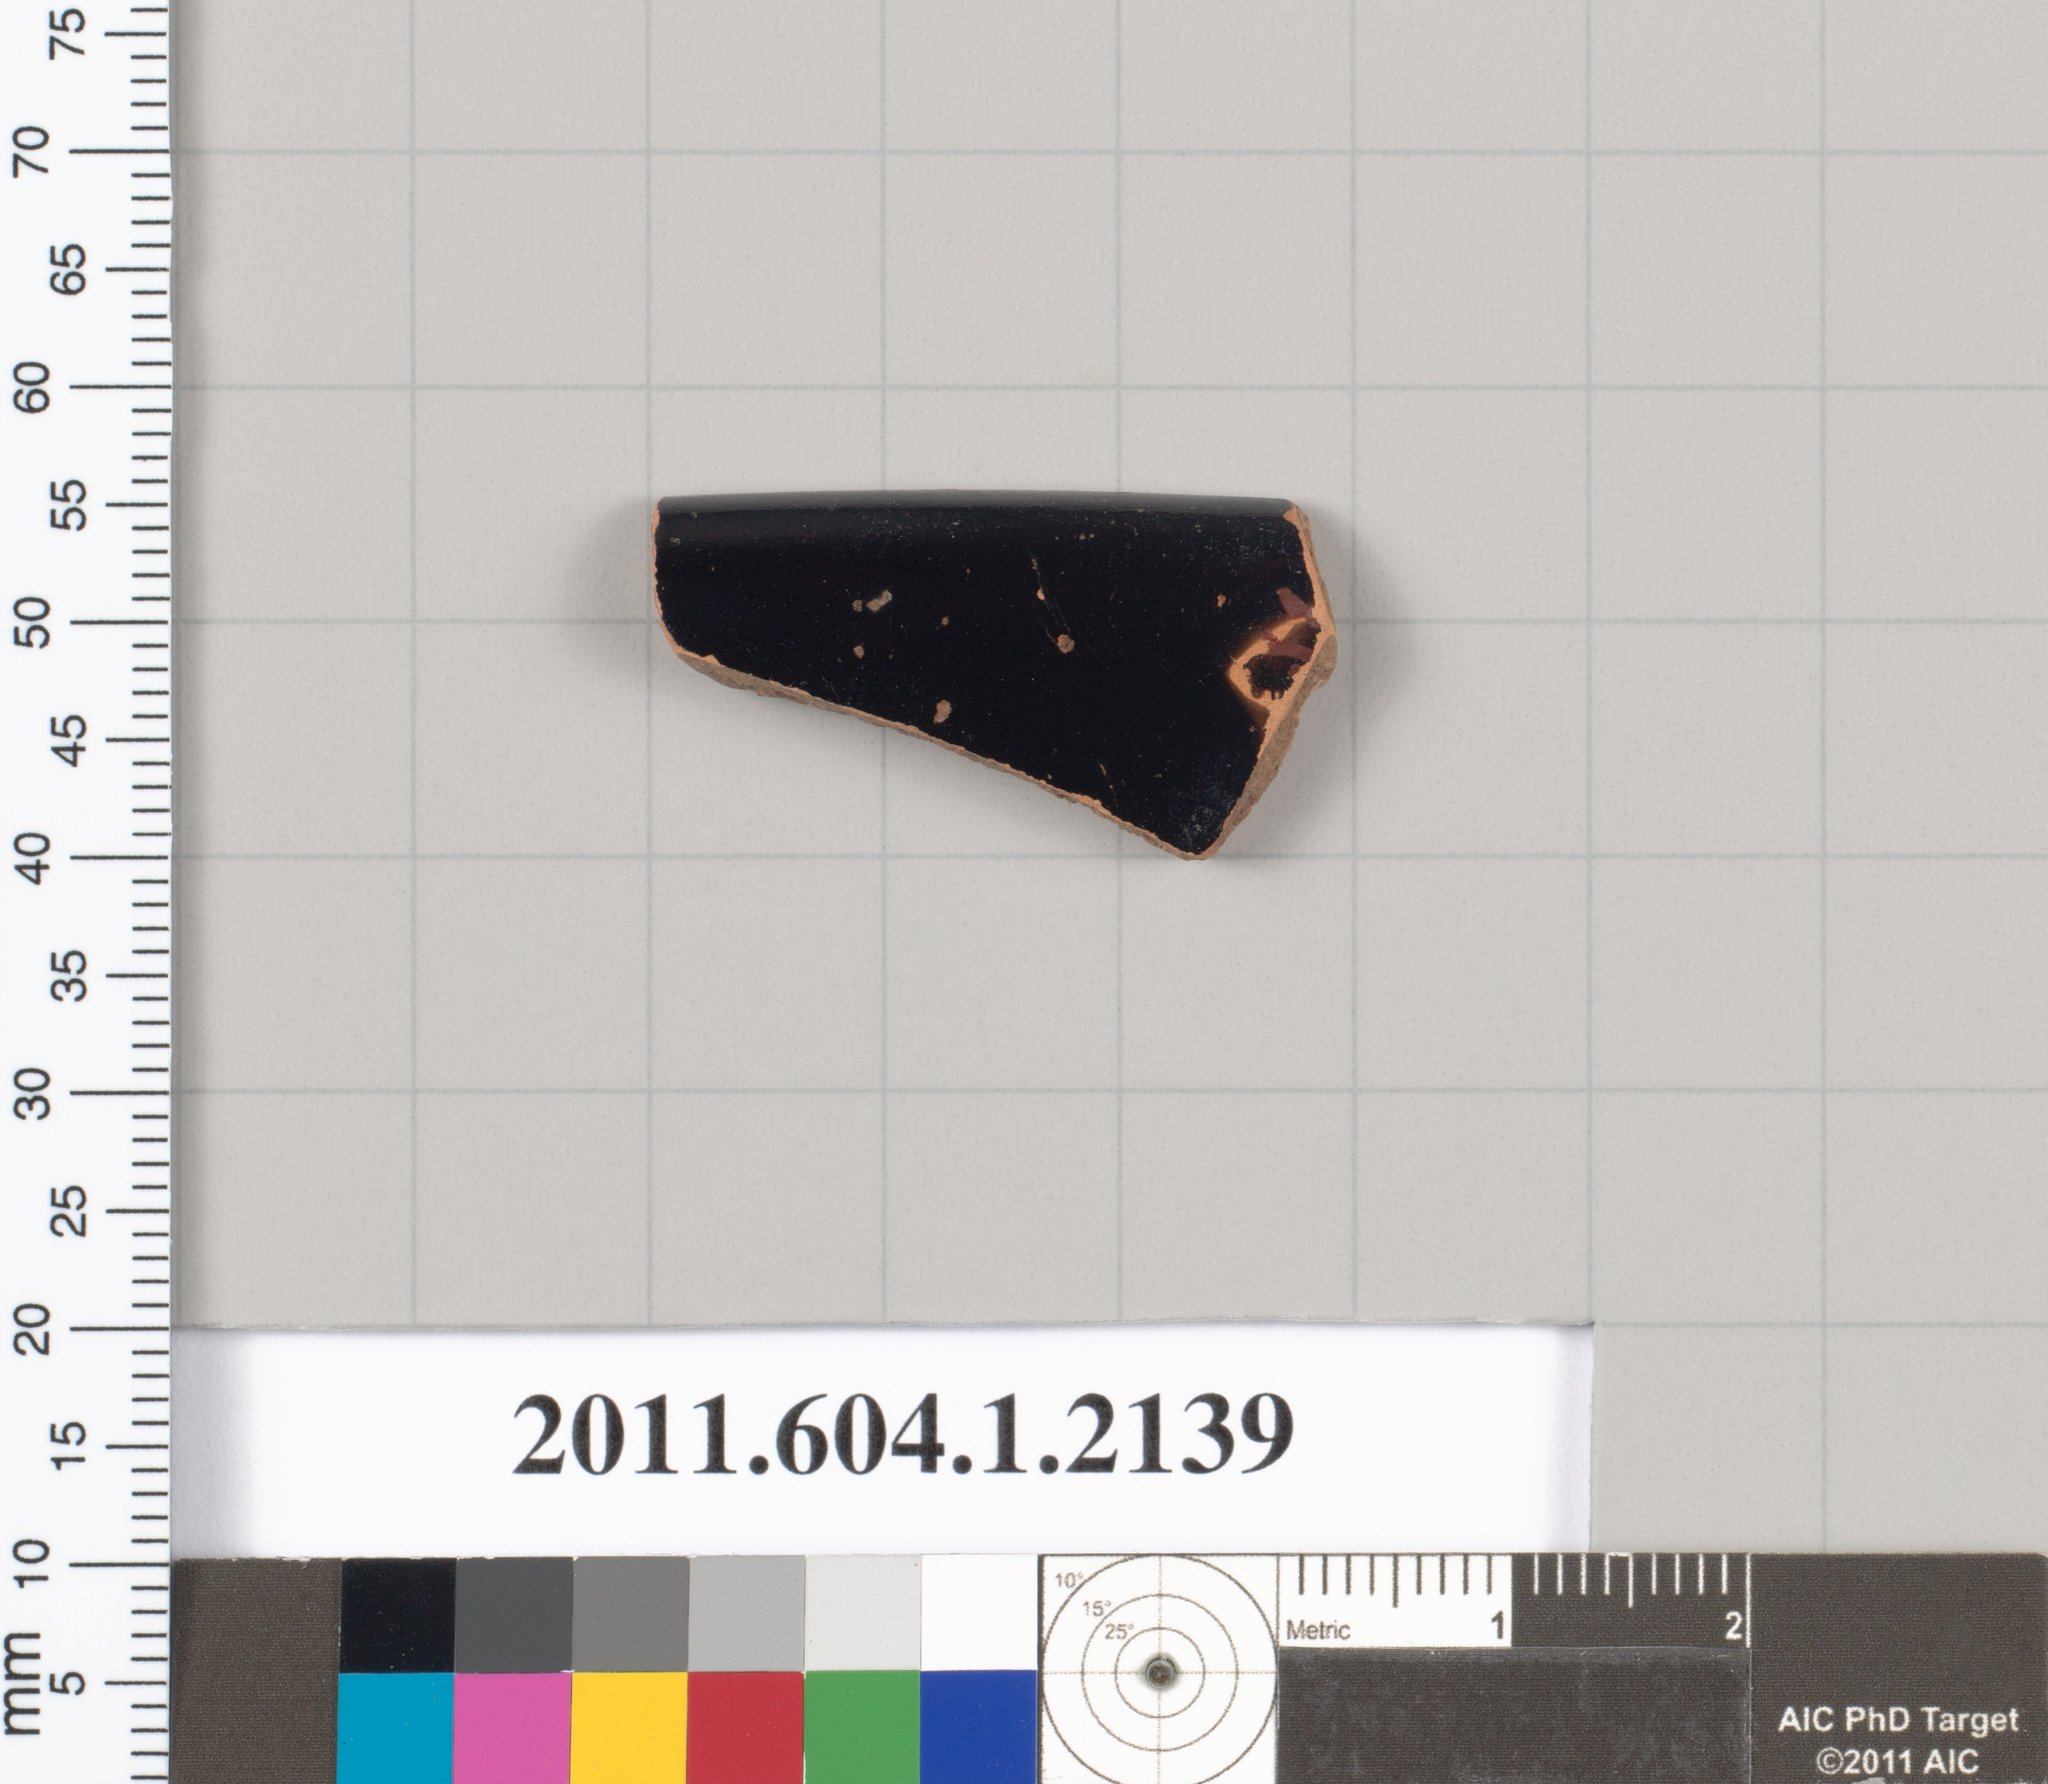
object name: kylix fragment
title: Terracotta rim fragment of a kylix (drinking cup)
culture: greek, attic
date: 500-451 BCE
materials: terracotta